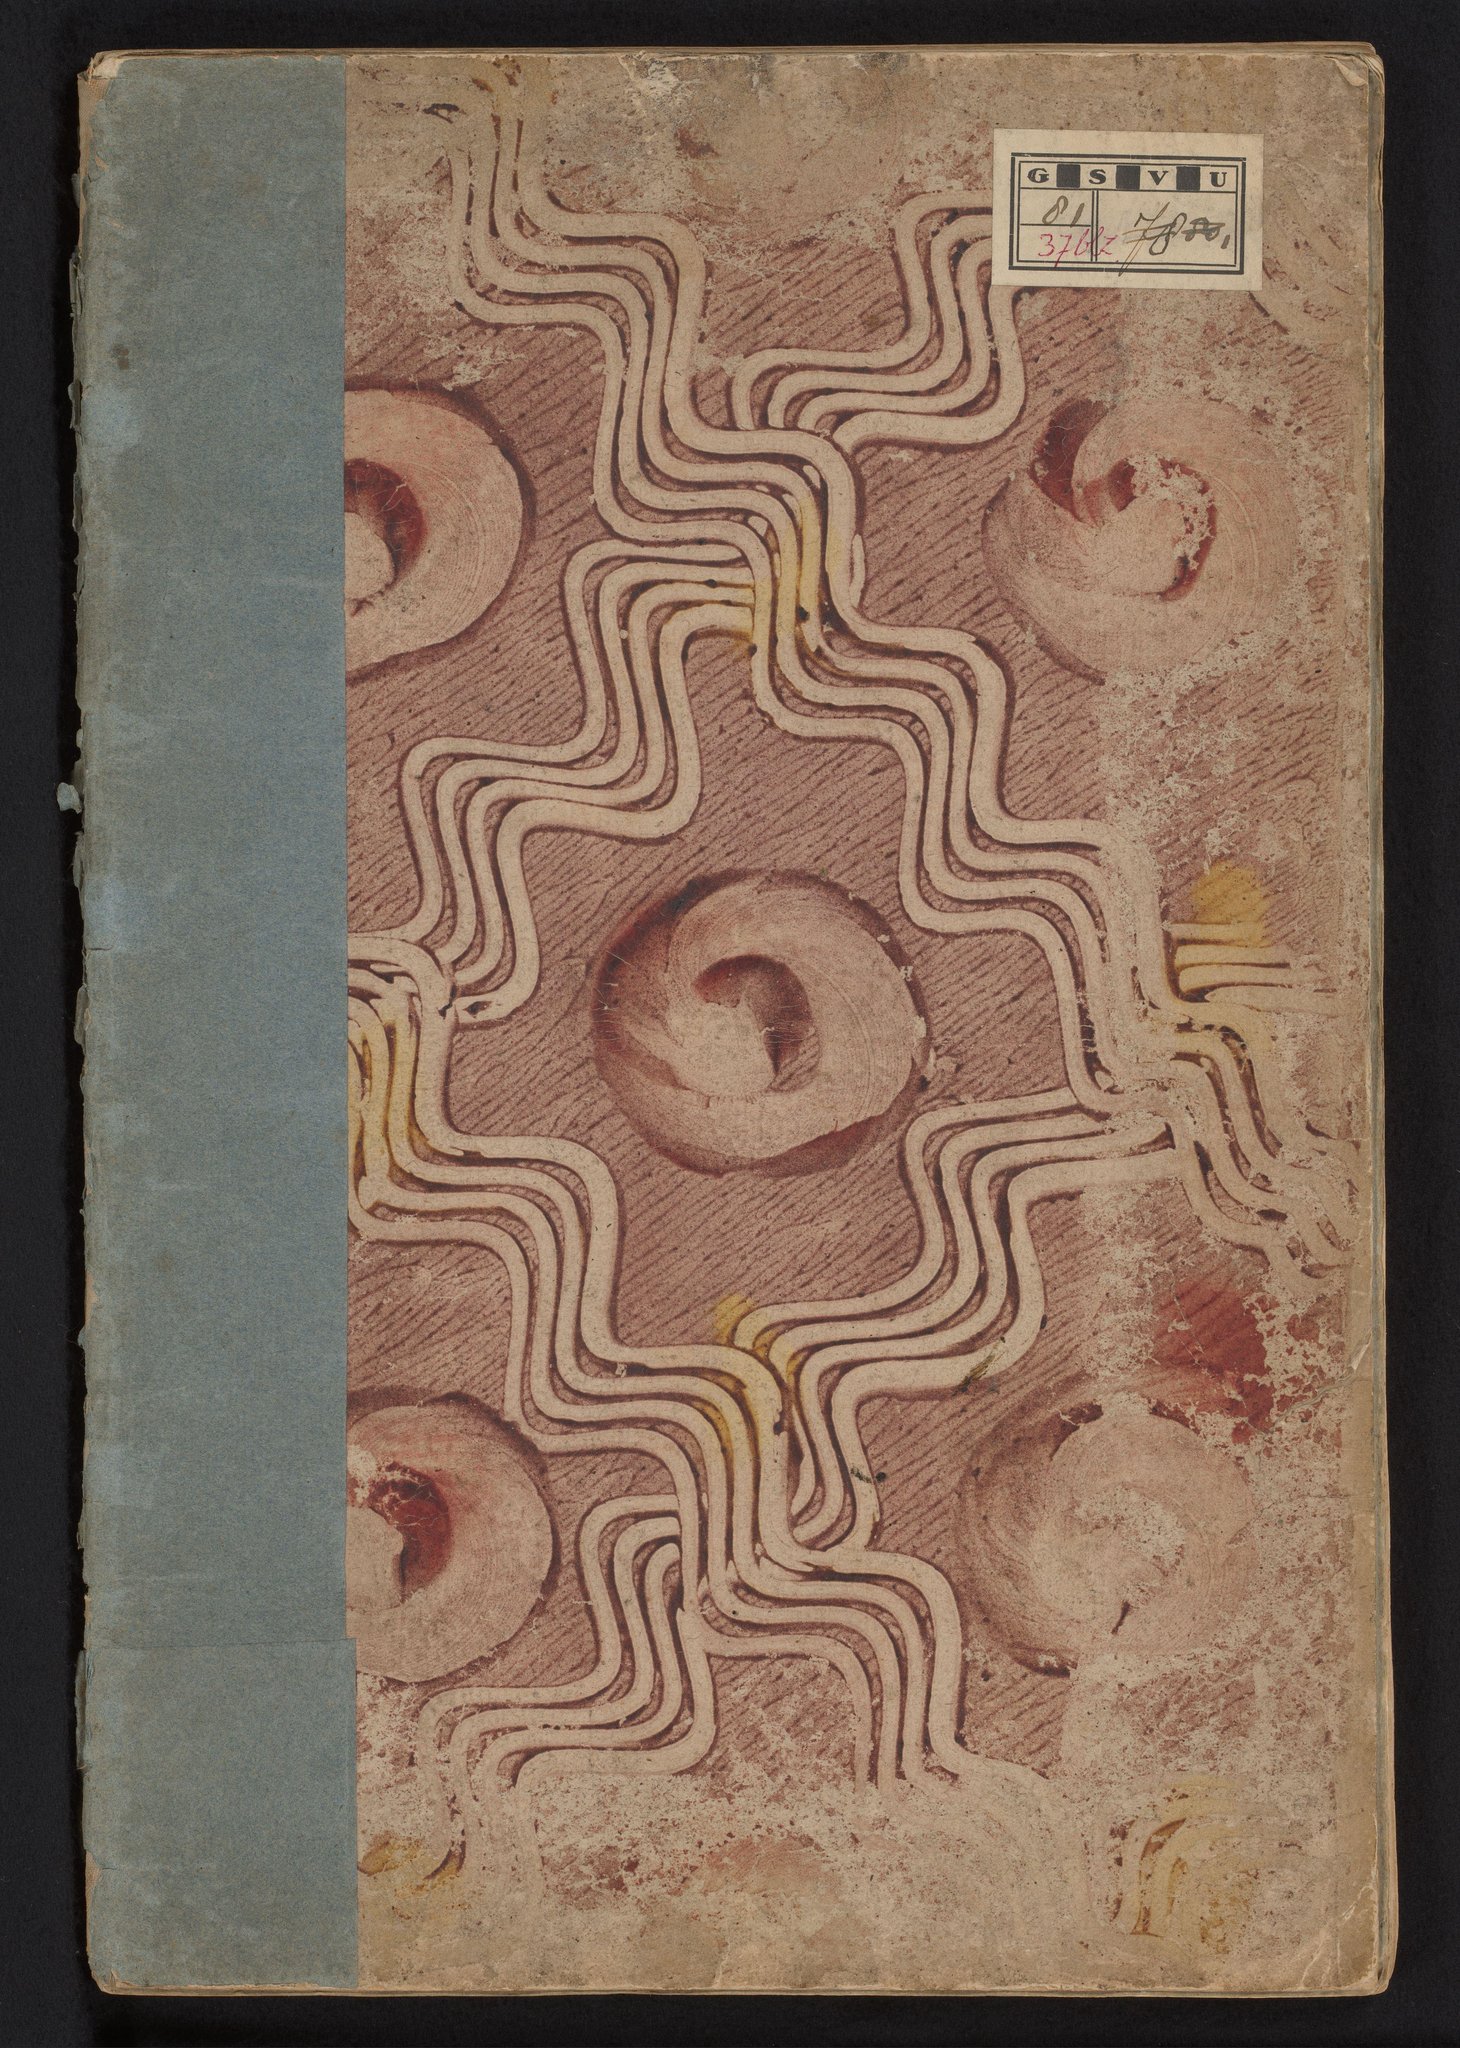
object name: prentrecueil, prentenalbum, prentalbum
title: Album met kalligrafische schrijfvoorbeelden van Bastiaan en Maarten Boers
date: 1660-1751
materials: paper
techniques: bookbinding, decorated paper, engraving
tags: calligraphy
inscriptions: collector's mark: ‘B’, collector's mark: ‘RIJKS / MUSM’, label, collector's mark: ‘Ronde stempel met wapen van Utrecht en daaromheen de tekst: School voor de Grafische Vakken te Utrecht’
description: Album met 37 voorstellingen op 37 albumbladen. Het gaat om kalligrafische schrijfvoorbeelden van Bastiaan en Maarten Boers. Album met kaften van sierpapier, voorin en achterin een schutblad.